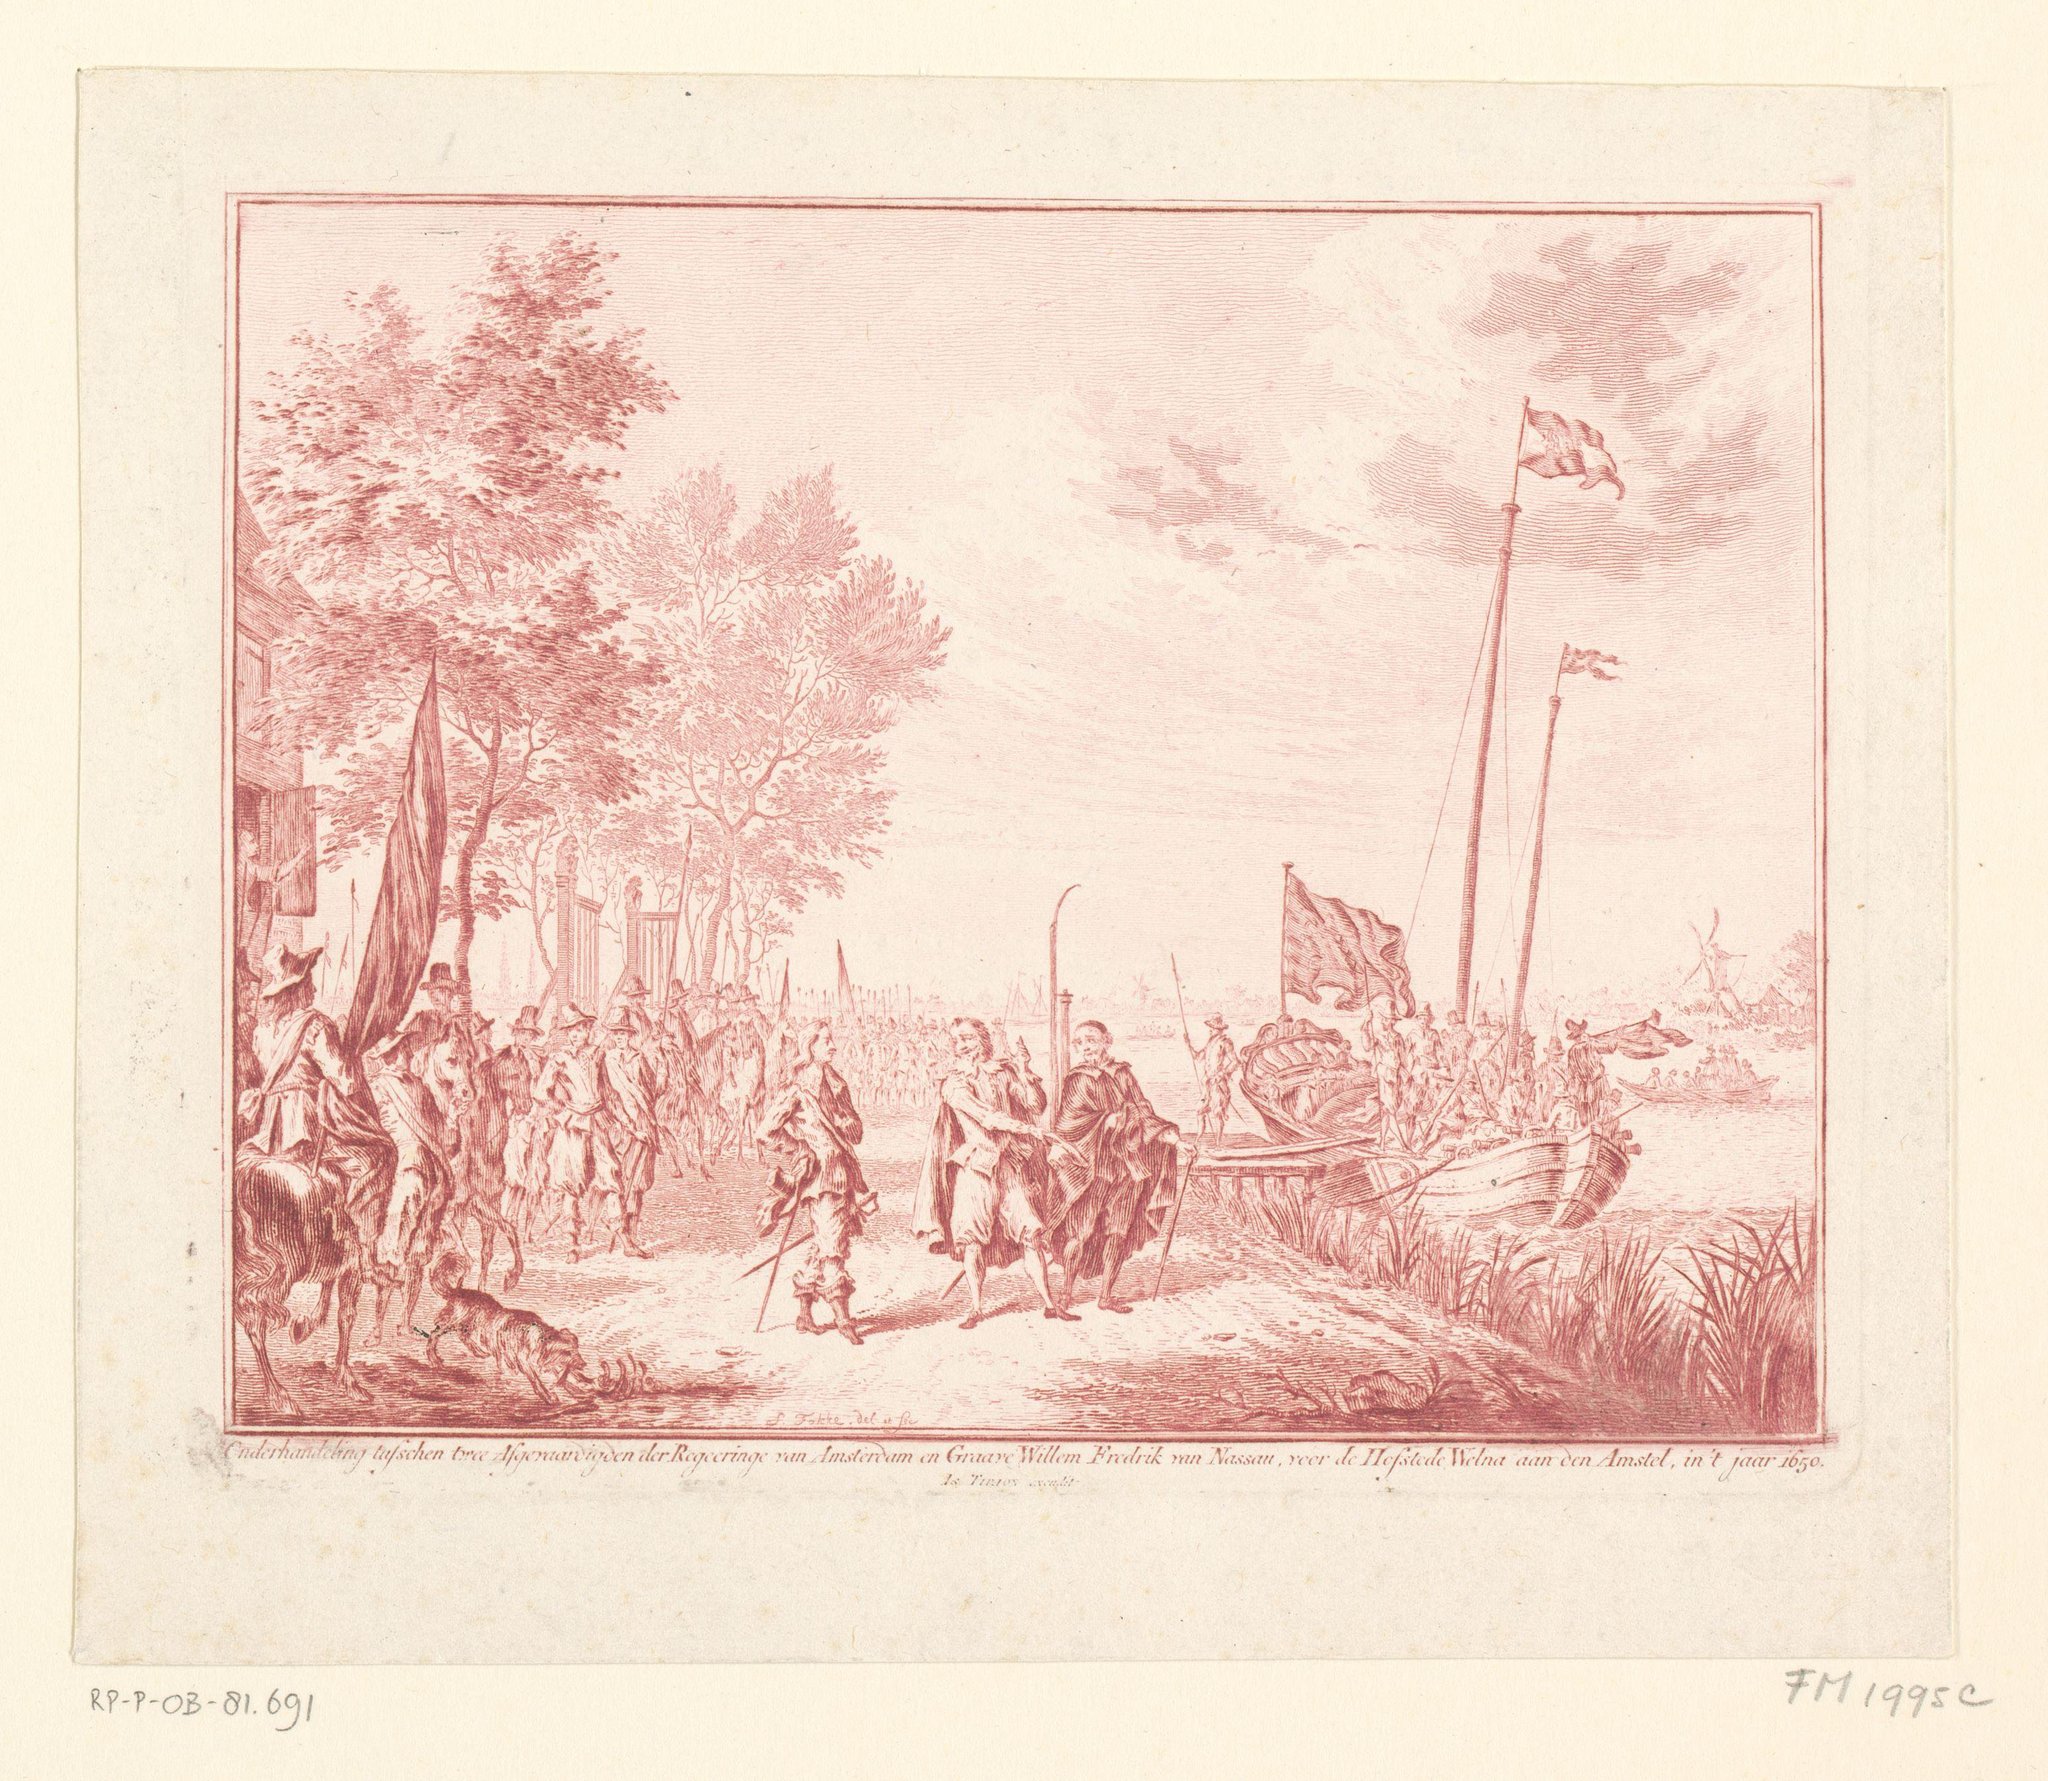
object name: print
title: Onderhandeling tussen afgevaardigden van Amsterdam en graaf Willem Frederik bij Hofstede Welna aan de Amstel, 1650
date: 1747-1759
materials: paper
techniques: etching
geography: northern netherlands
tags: arnhem, william ii (prince of orange), peace negotiations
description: Onderhandeling tussen twee afgevaardigden van de stad Amsterdam en stadhouder Willem Frederik voor Hofstede Welna aan de Amstel, 29-30 juli 1650. Rechts het Statenjacht.